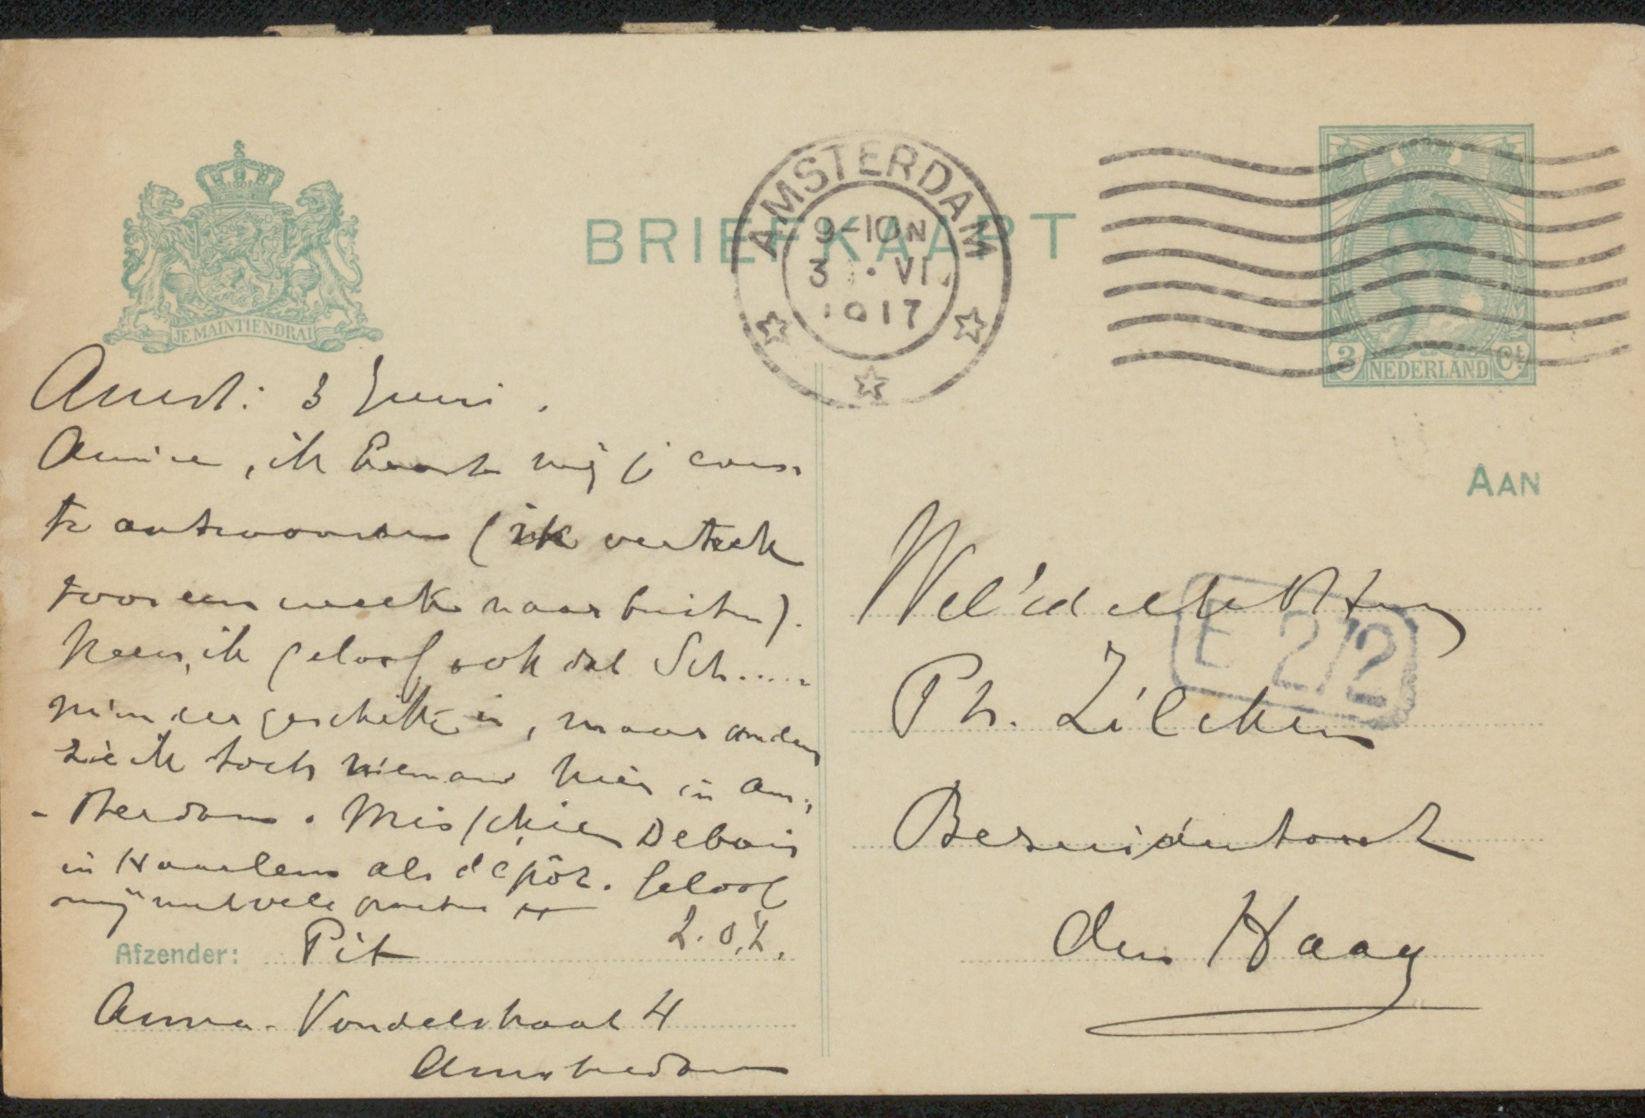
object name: postcard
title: Briefkaart aan Philip Zilcken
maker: adriaan pit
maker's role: print maker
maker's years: 1860-1944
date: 1917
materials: cardboard, ink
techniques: pen, writing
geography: amsterdam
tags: the hague, painter, draughtsman, philip zilcken, haarlem, amsterdam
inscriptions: collector's mark: ‘RPK’